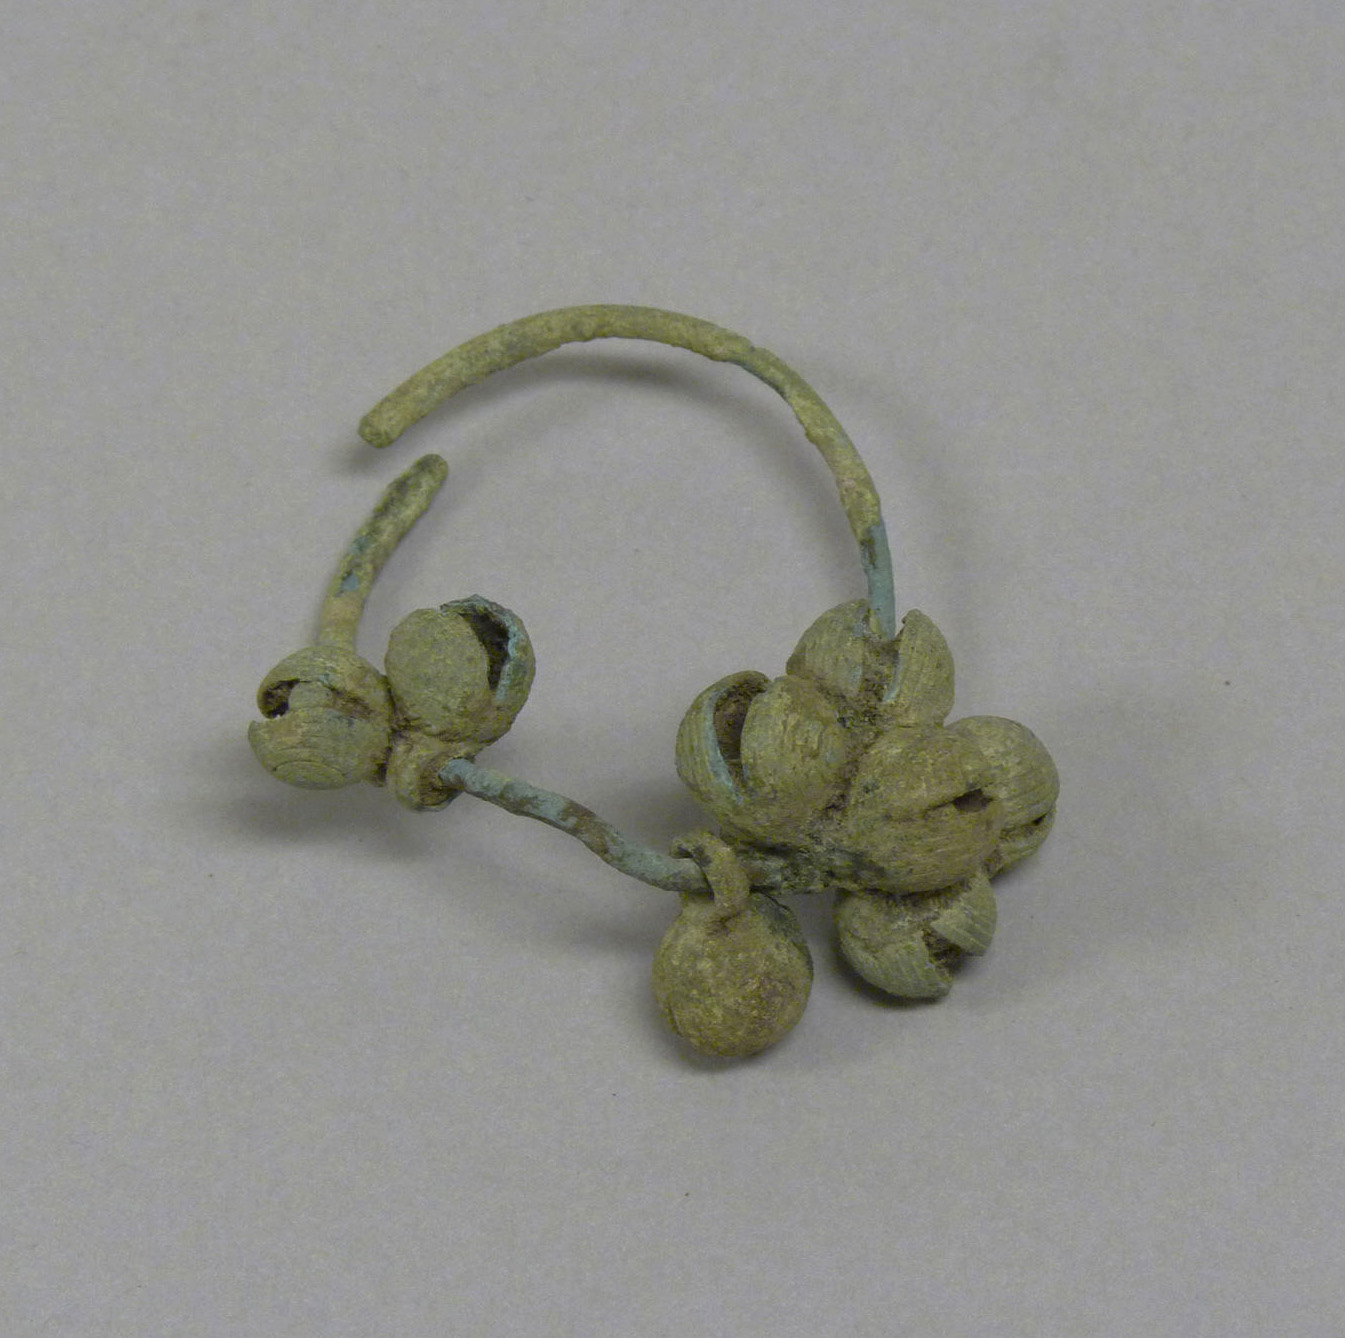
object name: bangle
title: Thin Bangle with Attached Balls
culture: thai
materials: bronze